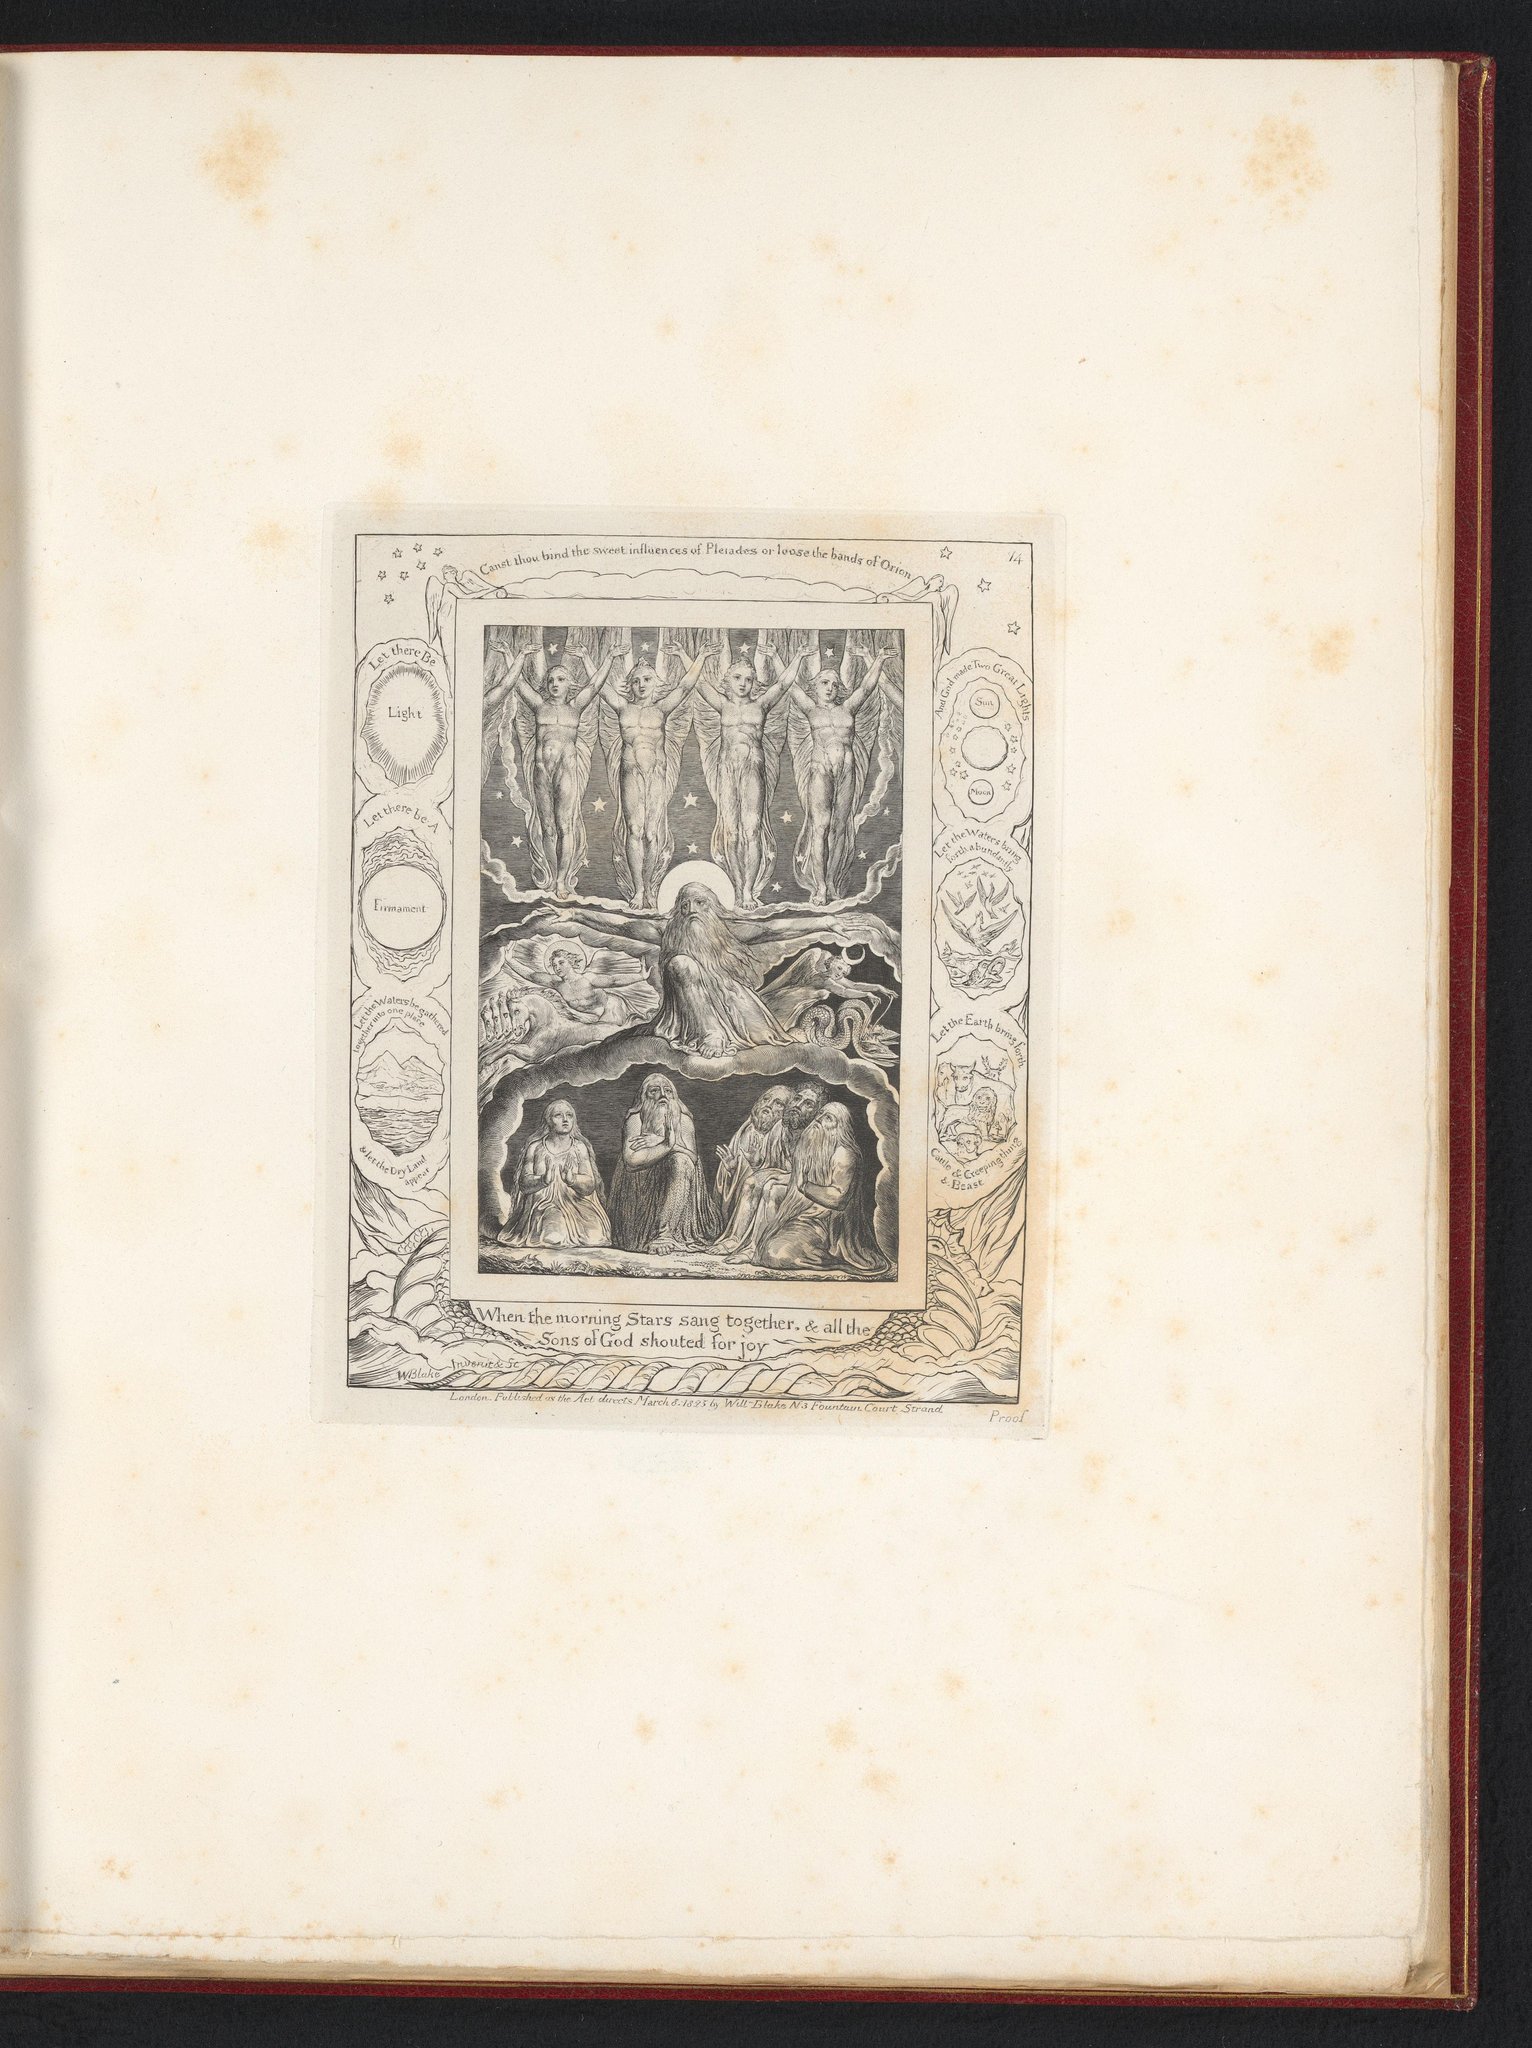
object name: album leaf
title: Gods antwoord aan Job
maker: william blake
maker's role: print maker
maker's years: 1757-1827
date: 1825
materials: paper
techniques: engraving, etching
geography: london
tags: when the morning stars sang together ~ god speaks to job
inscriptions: collector's mark: Lugt 2228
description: Prent maakt deel uit van een serie van 21 prenten. Er bestaan 150 afdrukken van de serie met daarop 'proof'.